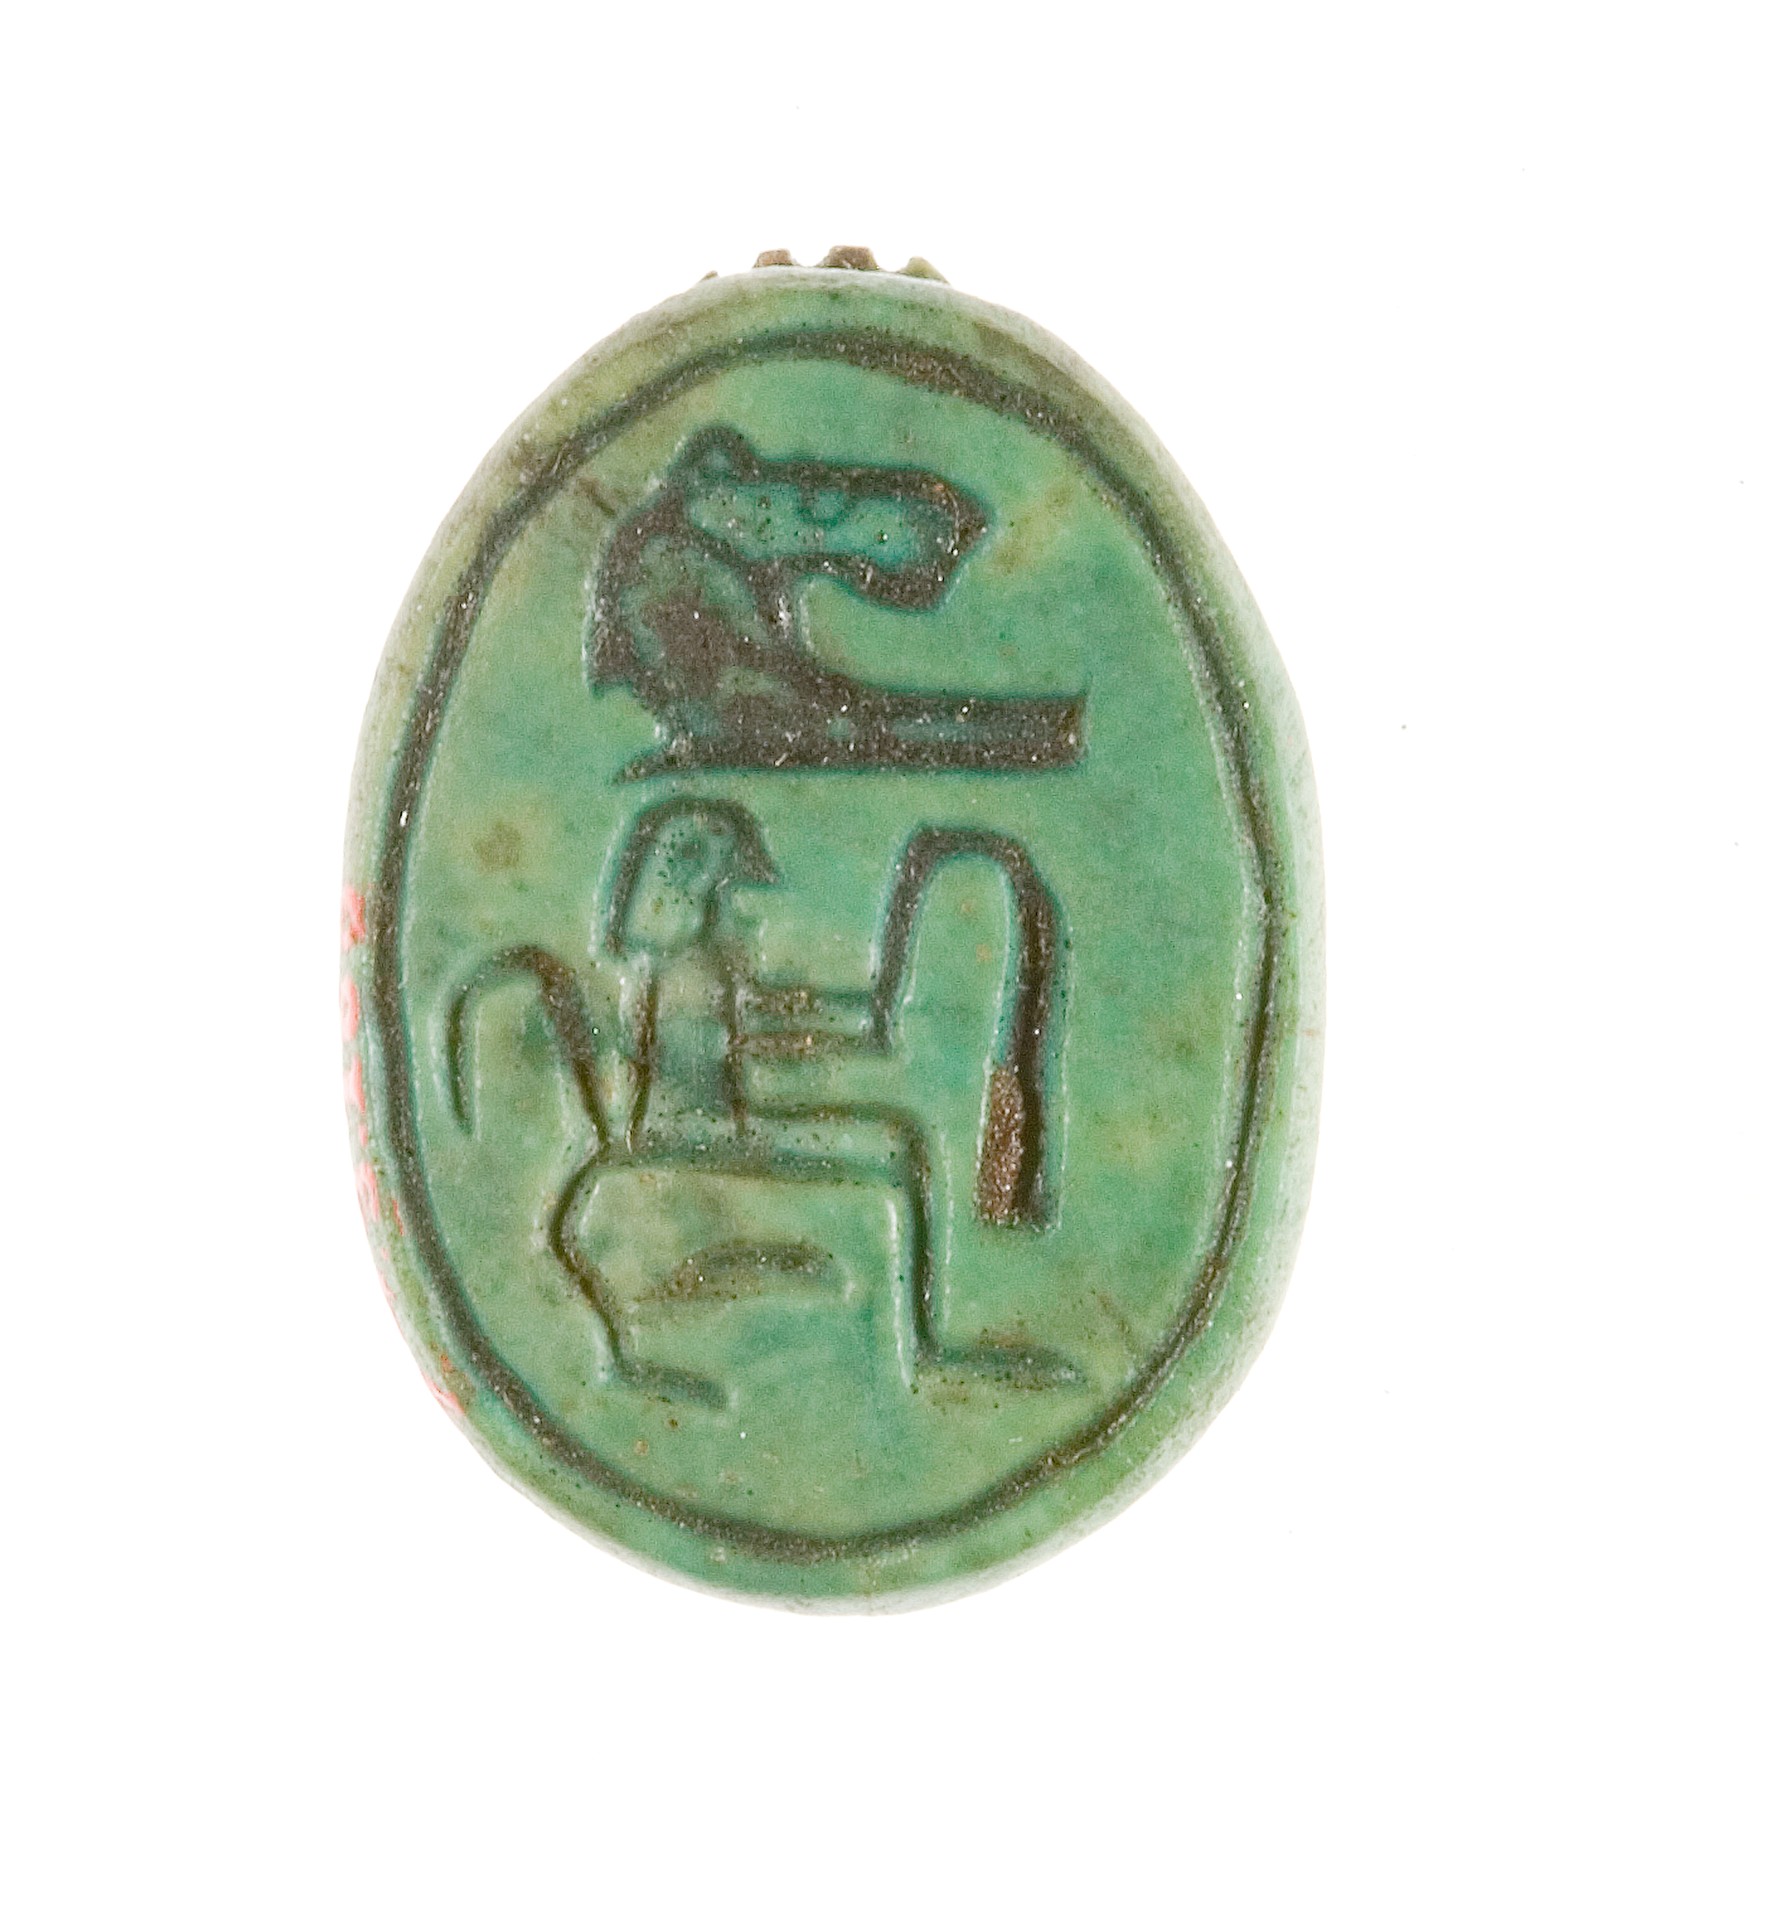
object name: scarab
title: Scarab Inscribed for Hatshepsut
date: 1479-1458 BCE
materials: stone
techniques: glazing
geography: egypt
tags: scarabs